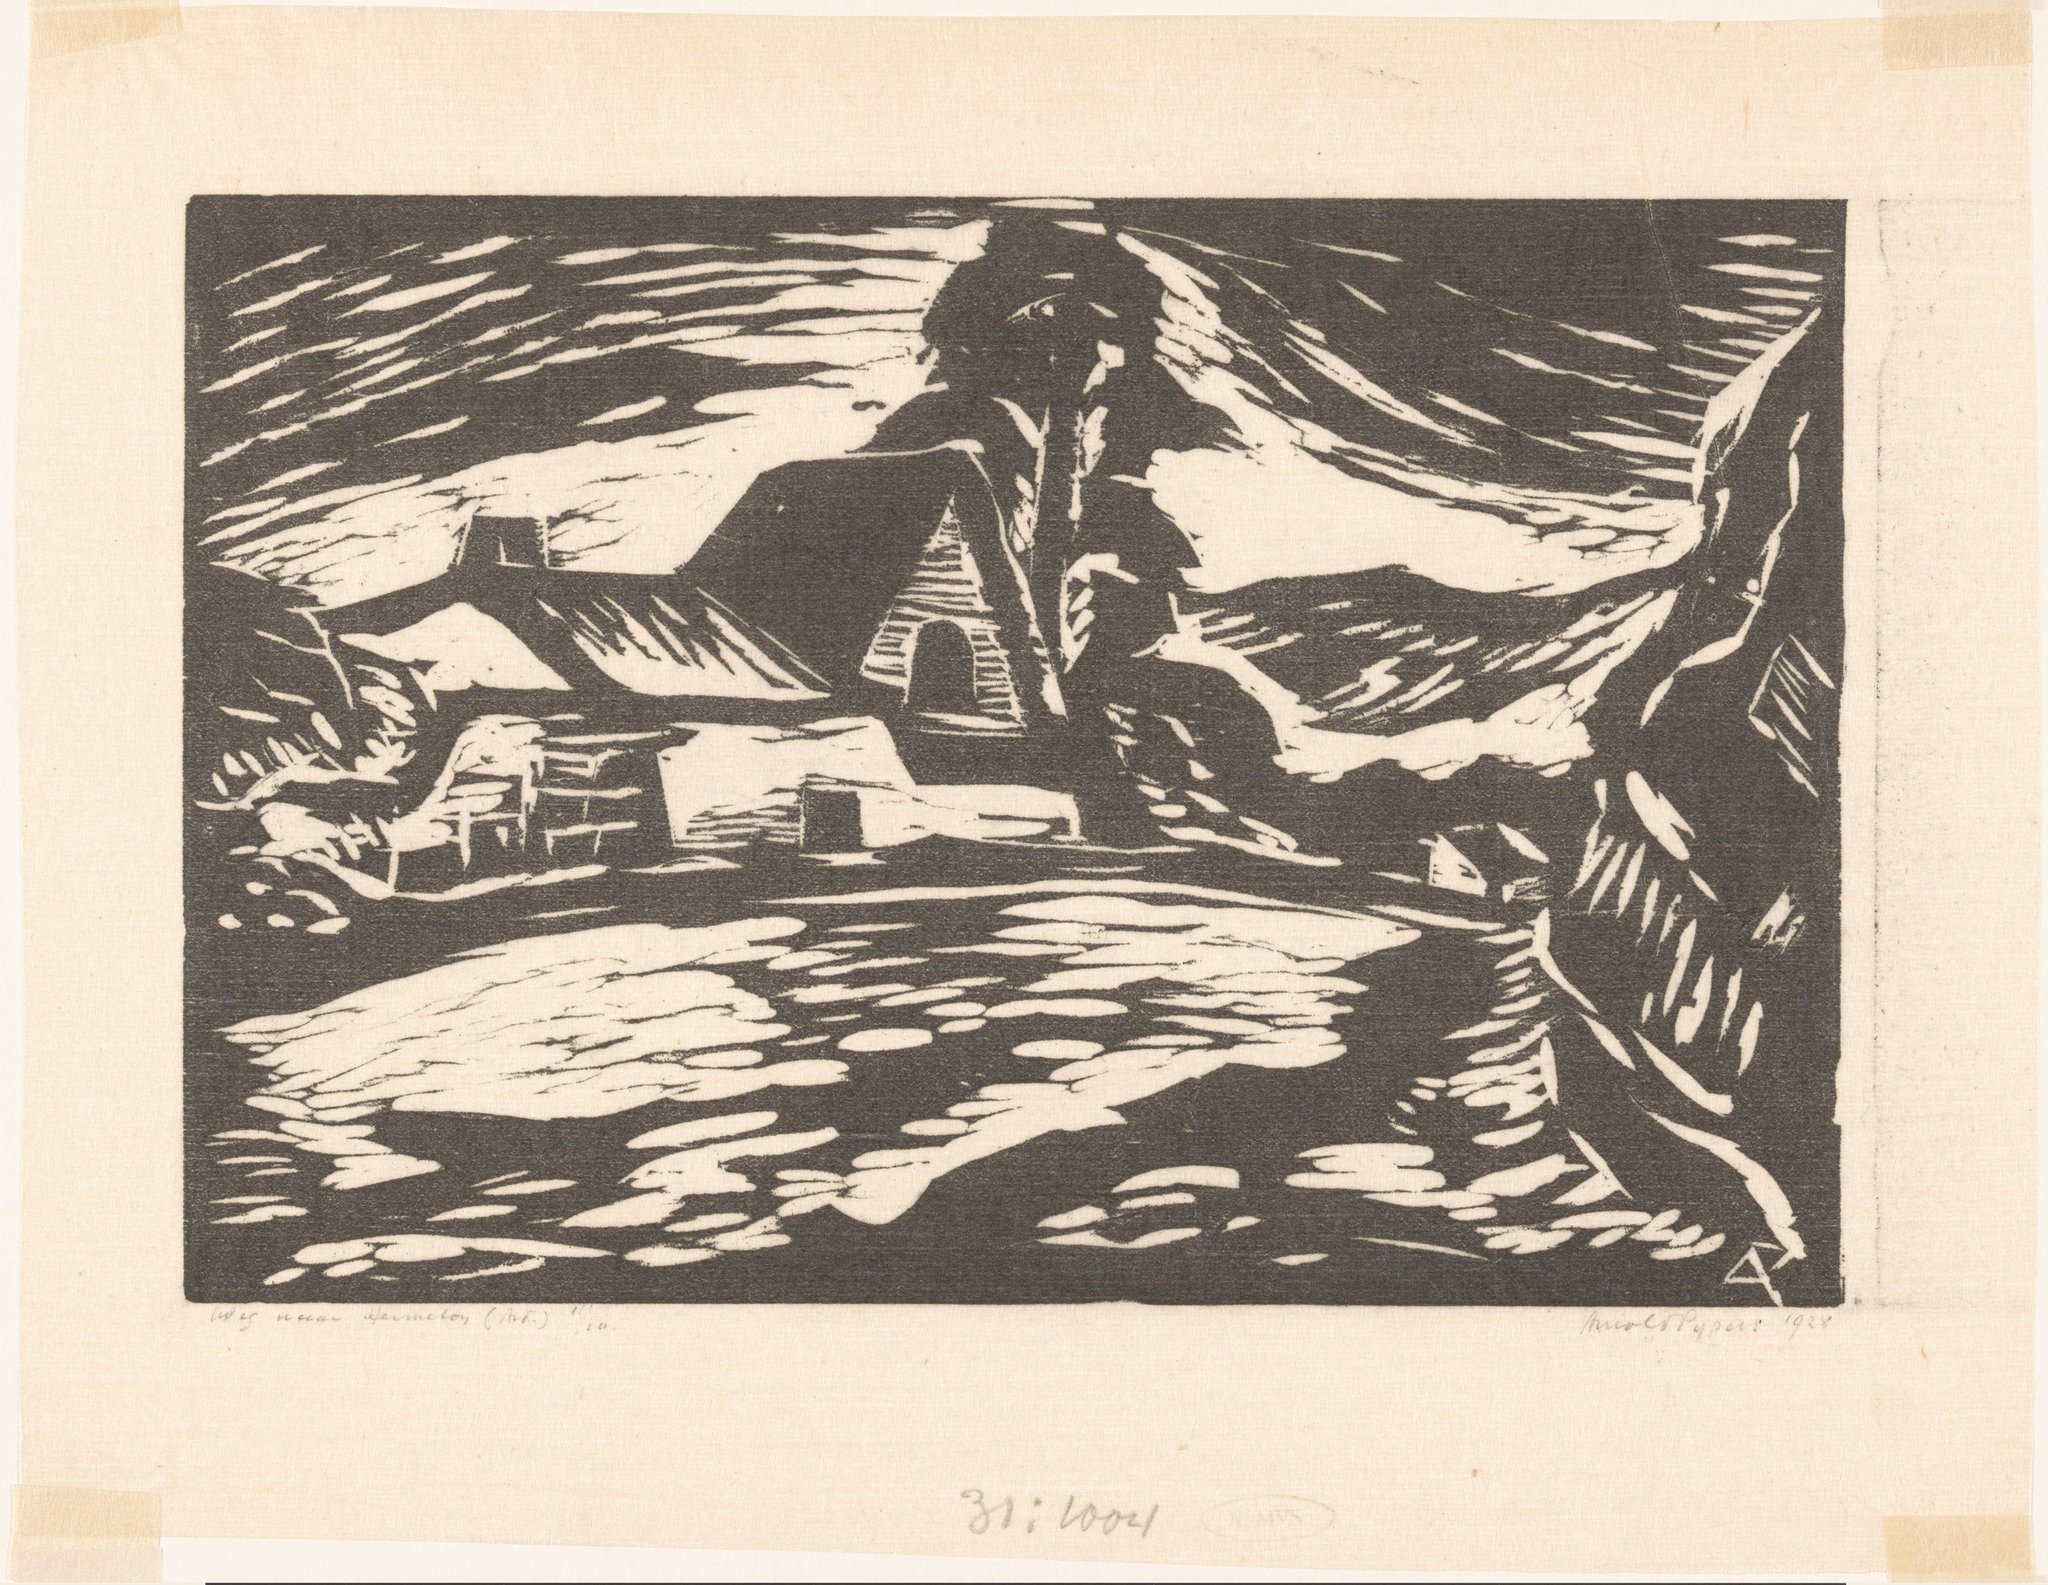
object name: print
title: Weg naar Hermeton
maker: arnold pijpers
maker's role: print maker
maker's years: 1900-1951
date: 1928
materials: paper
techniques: woodcut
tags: road, path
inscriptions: collector's mark: Lugt 2228